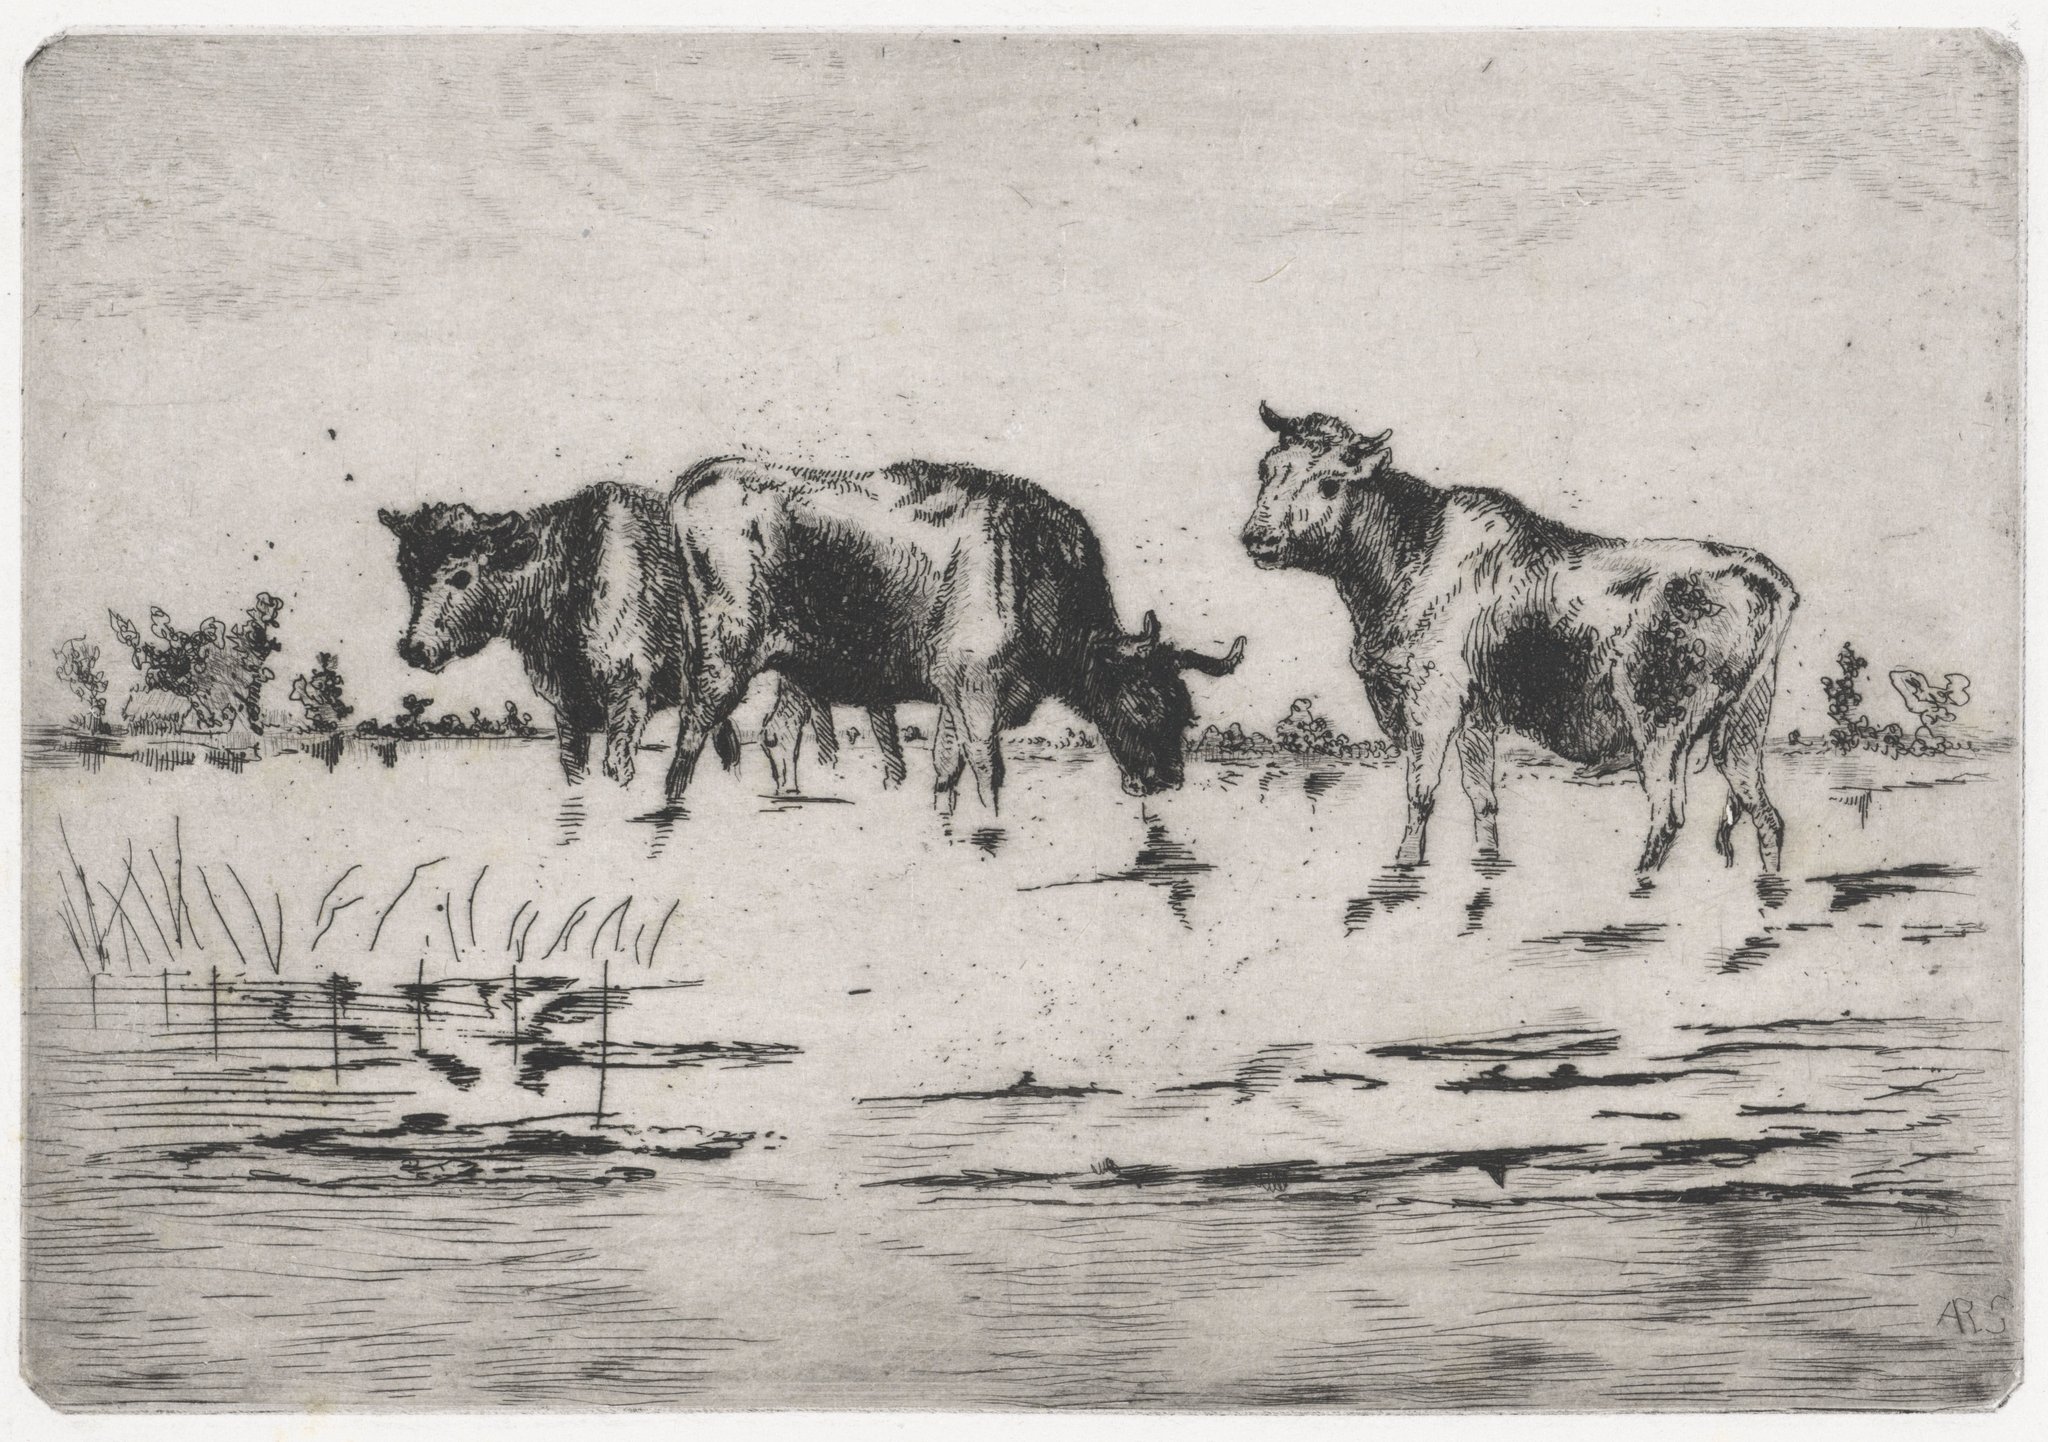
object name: print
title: Koeien in een ondergelopen weiland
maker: arnoud schaepkens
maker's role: print maker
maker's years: 1816-1904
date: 1831-1904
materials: paper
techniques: drypoint, etching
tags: cow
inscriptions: collector's mark: Lugt 2228